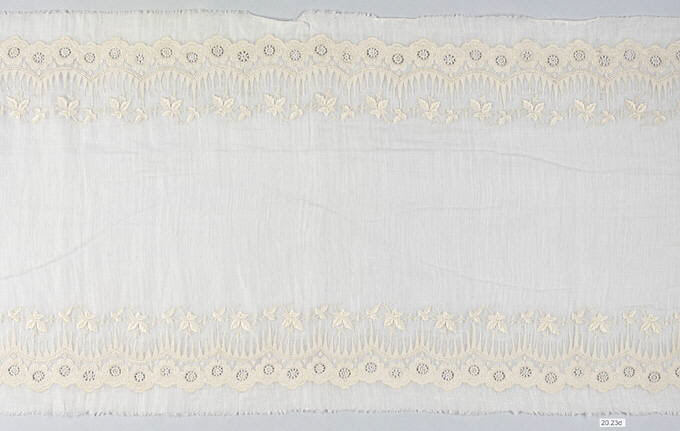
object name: strip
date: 1834-1866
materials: cotton